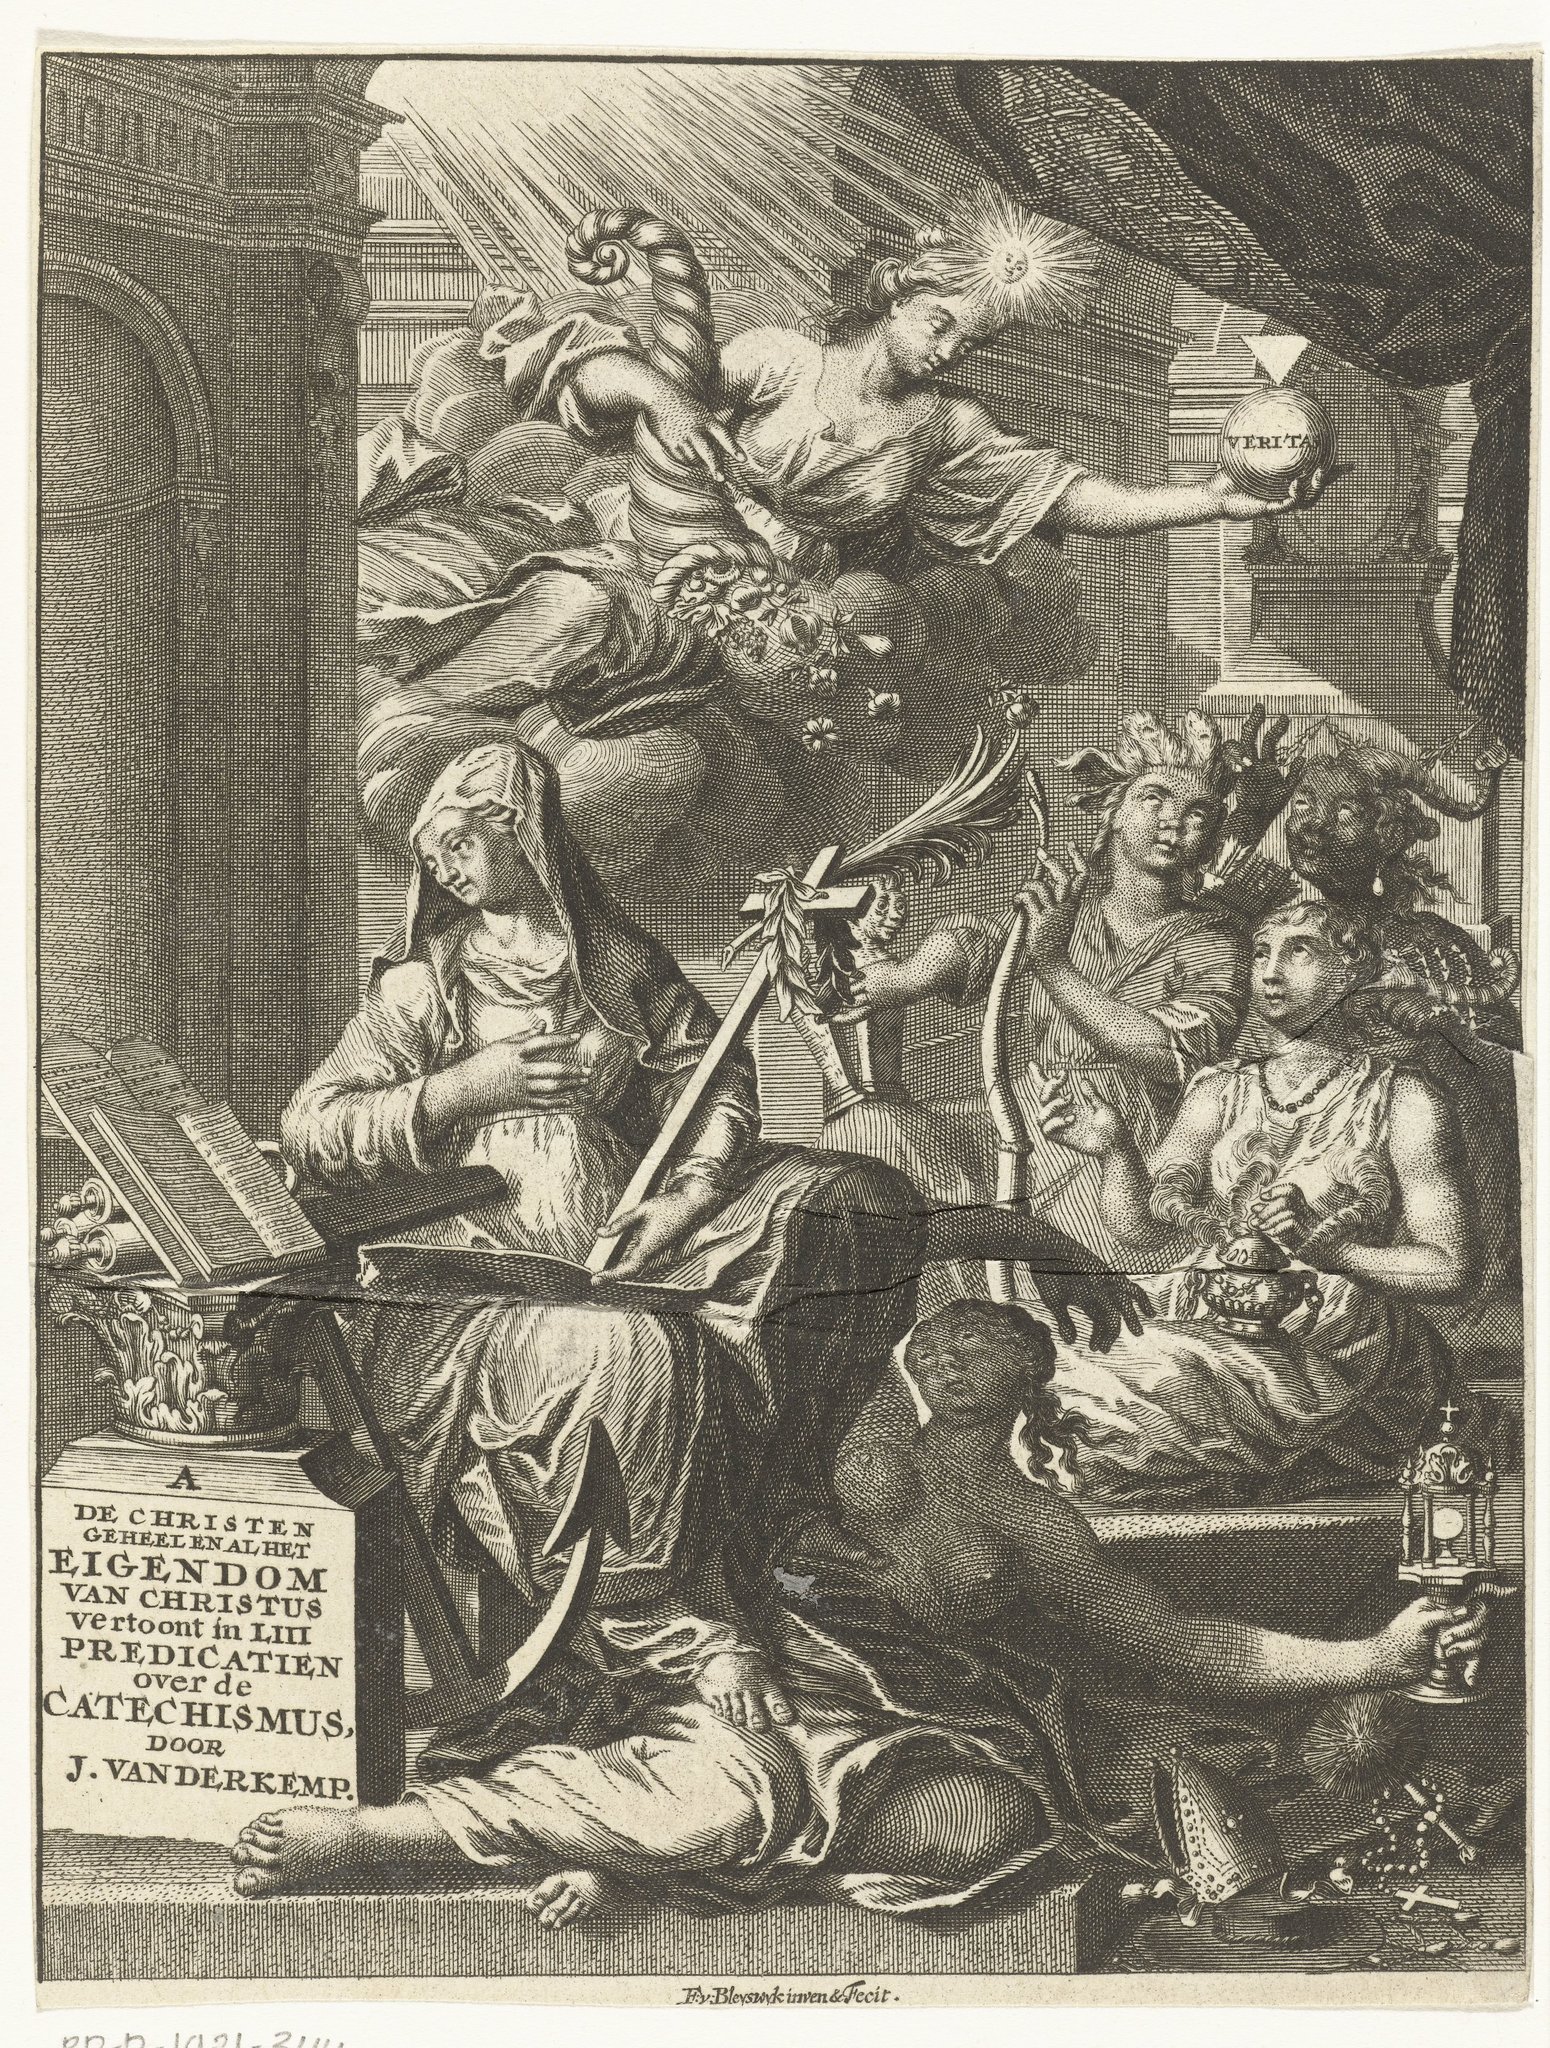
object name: print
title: Allegorie met vrouwelijke personificaties van onder andere de waarheid en mogelijk deugden en ondeugden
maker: françois van bleyswijck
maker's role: draughtsman, print maker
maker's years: 1671-1746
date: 1681-1746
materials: paper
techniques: engraving, etching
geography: leiden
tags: the three theological virtues, truth; 'verità' (ripa)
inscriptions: collector's mark: Lugt 2228, collector's mark: Lugt 2233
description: Allegorie met vrouwelijke personificaties en mogelijk strijd tussen deugden en ondeugden. De personificatie van de waarheid zit op een wolk met in haar handen een hoorn des overvloeds en globe met het woord veritas. Een zittende vrouw met als attributen een kruis en anker trapt met haar voeten op een halfnaakte liggende vrouw die een monstrans vasthoudt. Drie zittende vrouwen met onder andere een wierookvat, pijlen en boog en een schorpioen kijken naar de verschijning van de waarheid.